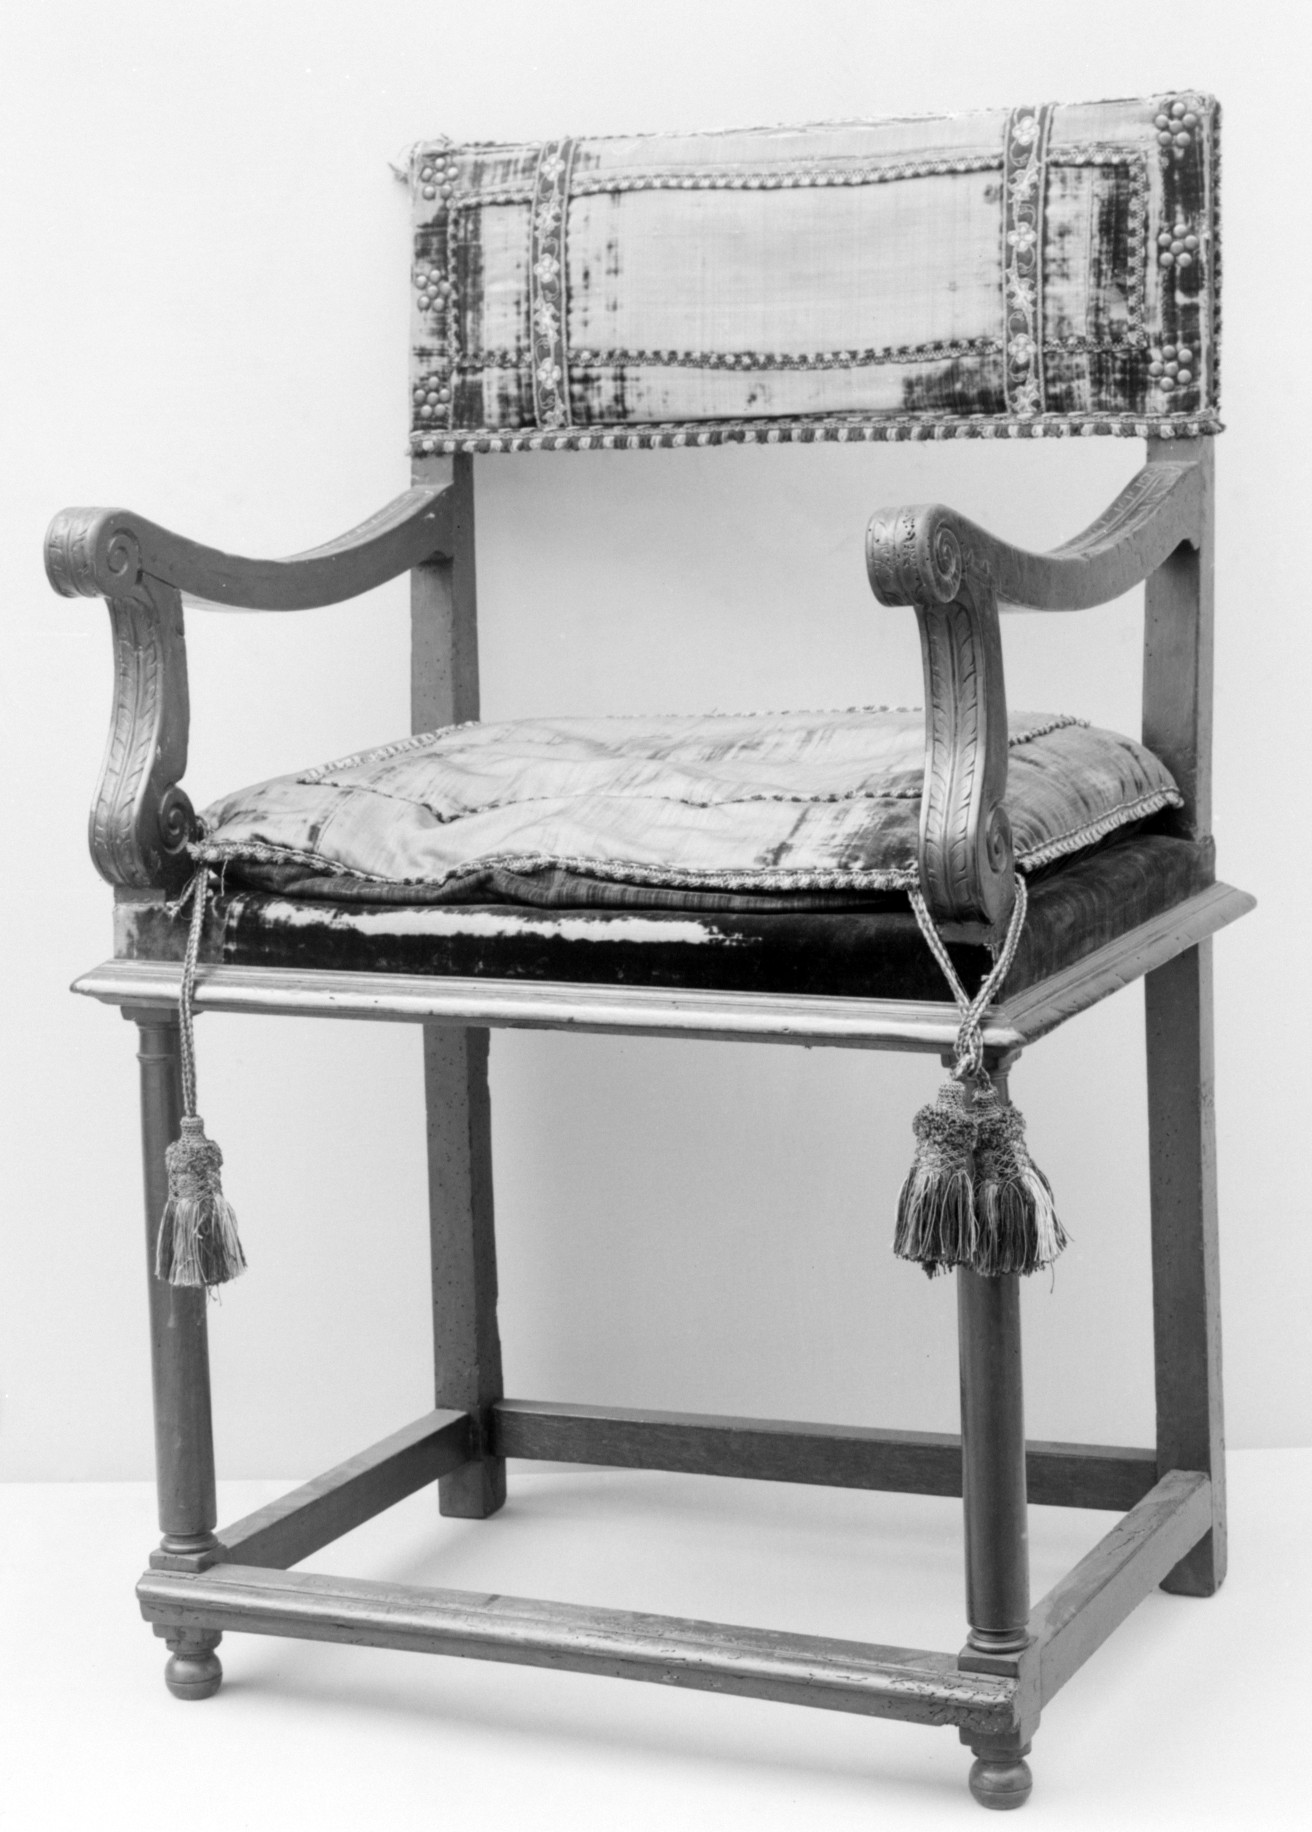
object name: armchair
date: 1601-1633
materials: wood